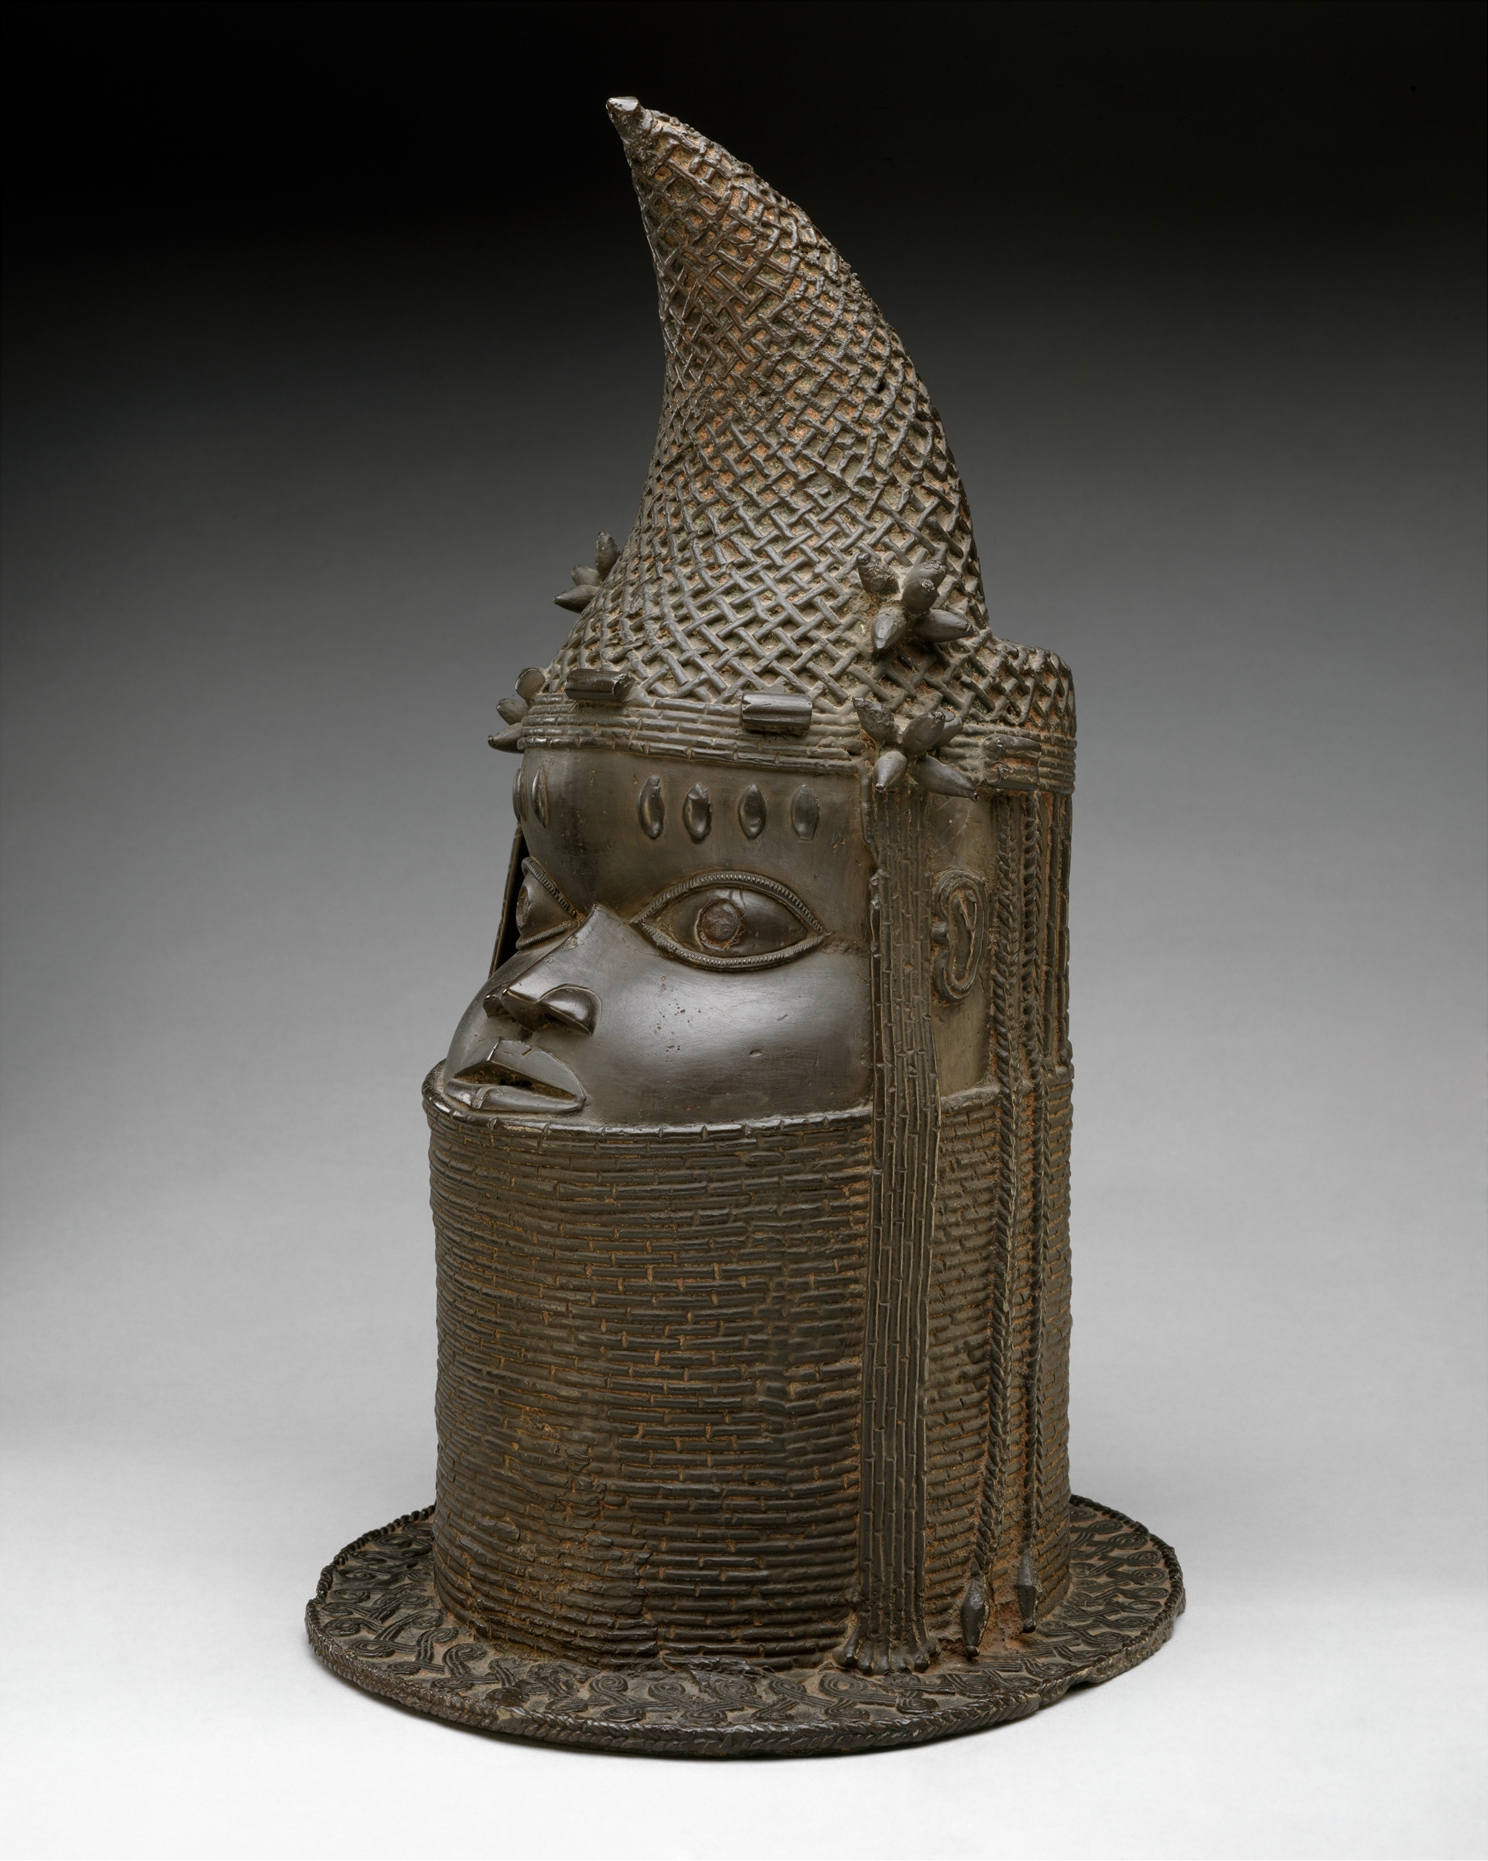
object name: head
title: Head of Iyoba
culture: edo period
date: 1701-1900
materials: brass, iron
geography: nigeria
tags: heads